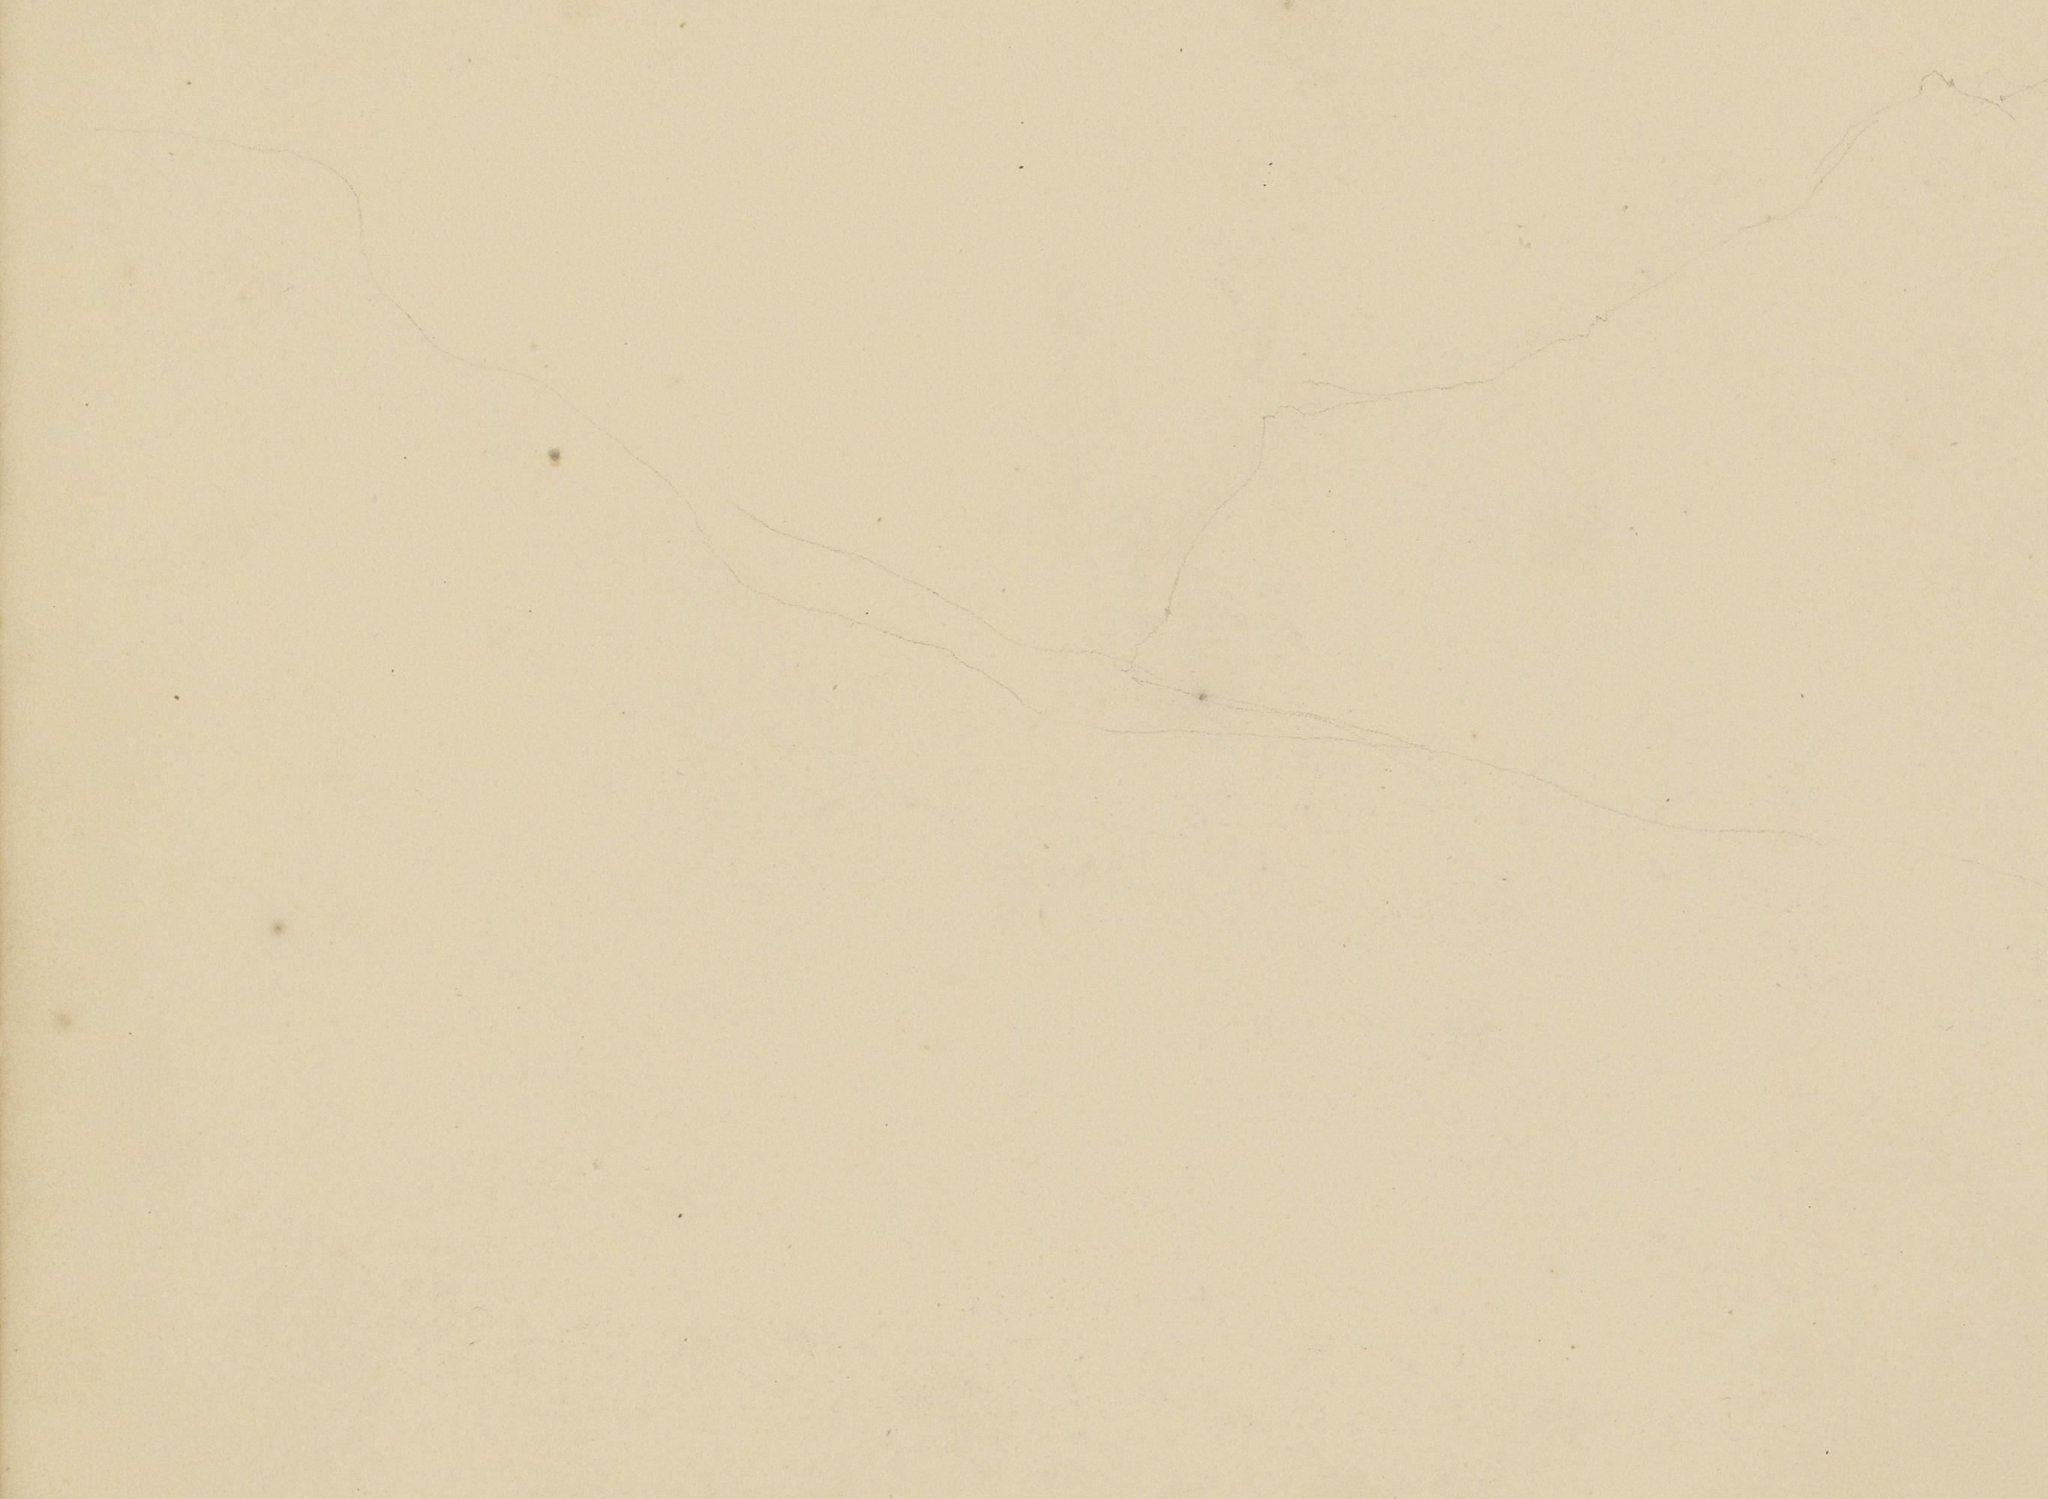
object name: sketchbook leaf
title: Bergen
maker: jacobus everhardus josephus van den berg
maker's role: draughtsman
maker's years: 1802-1861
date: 1830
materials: paper, pencil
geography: italy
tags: mountains, italy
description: Blad 24 verso uit een schetsboek met 26 bladen.